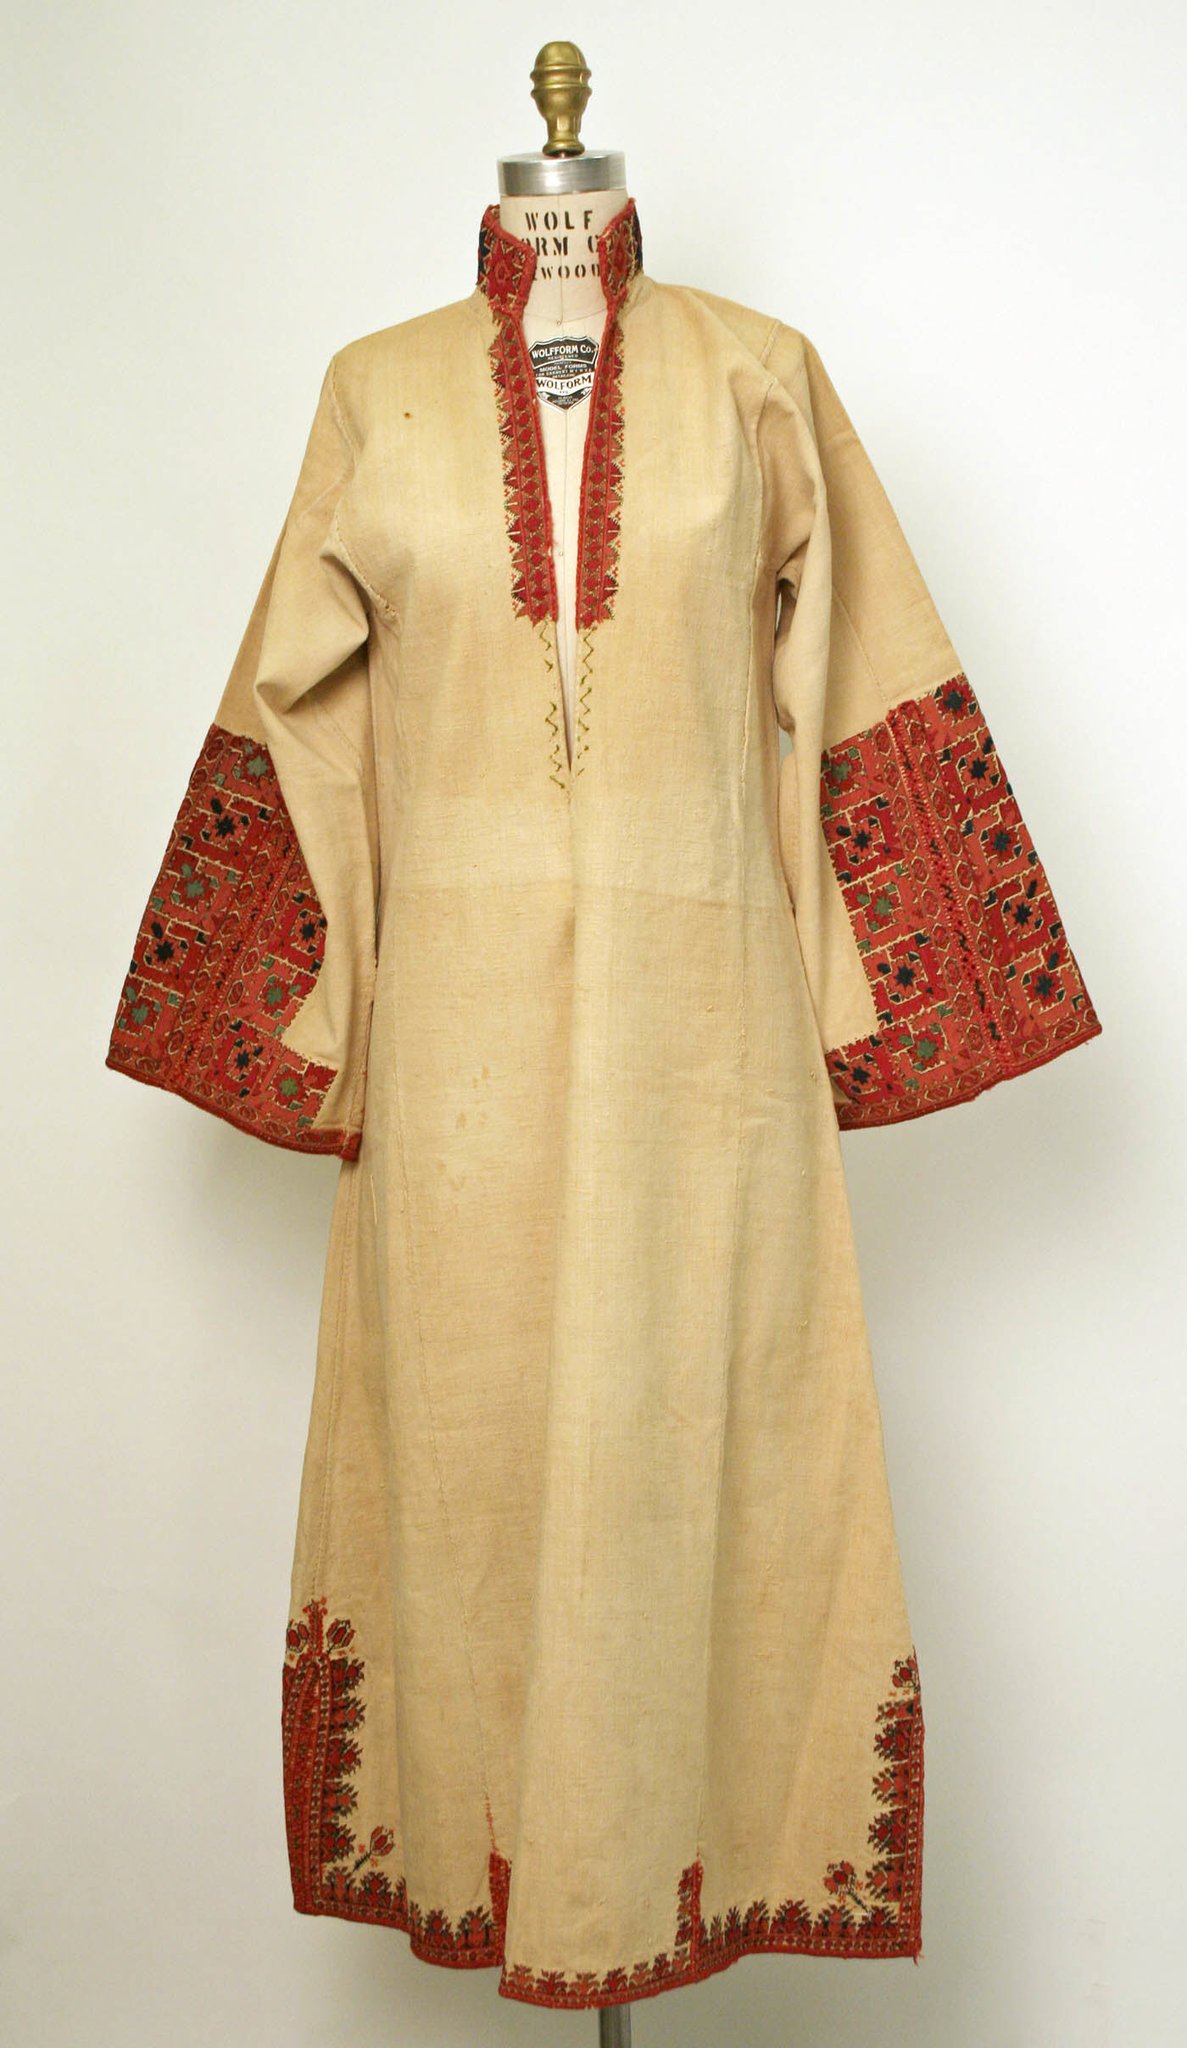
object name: dress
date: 1867-1900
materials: cotton